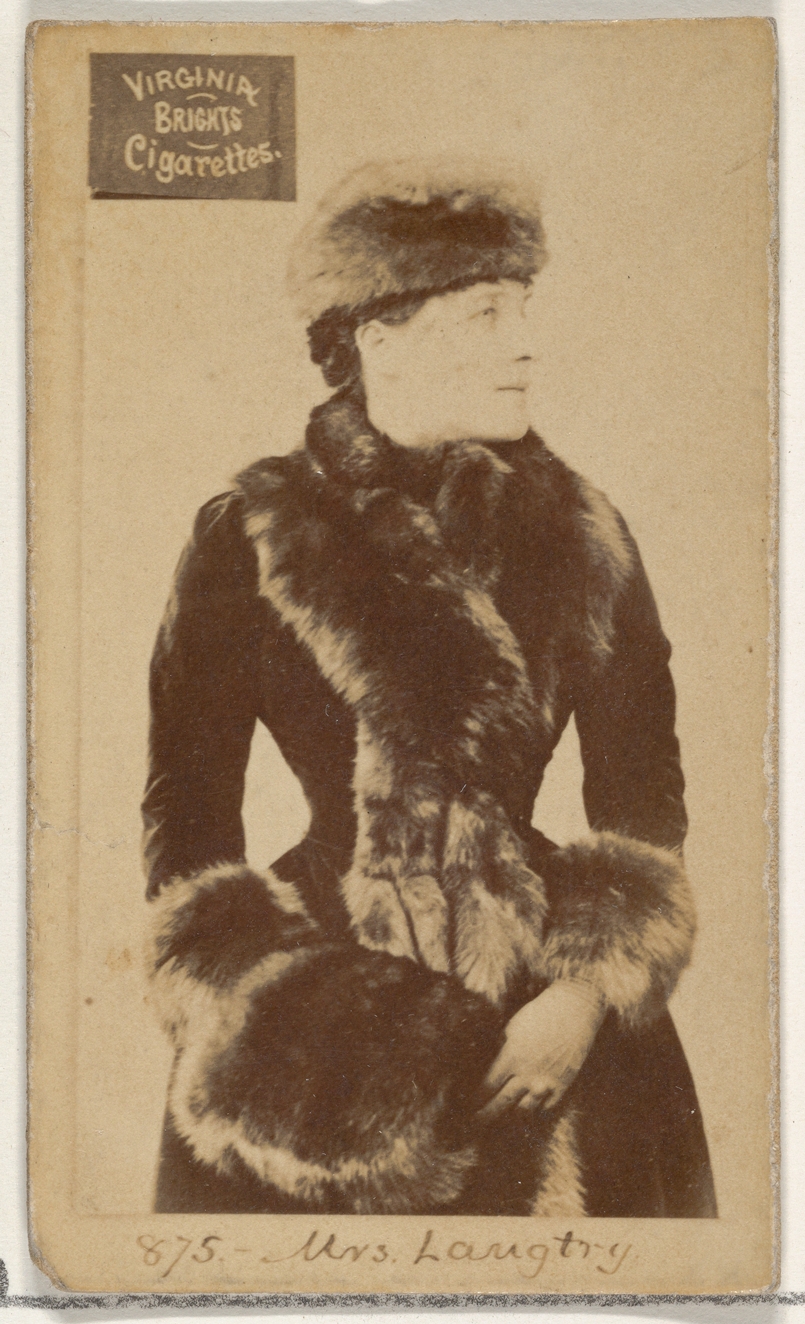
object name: photograph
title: Card 875, Mrs. Langtry, from the Actors and Actresses series (N45, Type 2) for Virginia Brights Cigarettes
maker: allen & ginter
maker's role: publisher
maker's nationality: american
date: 1888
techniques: albumen silver print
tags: portraits,women,actresses